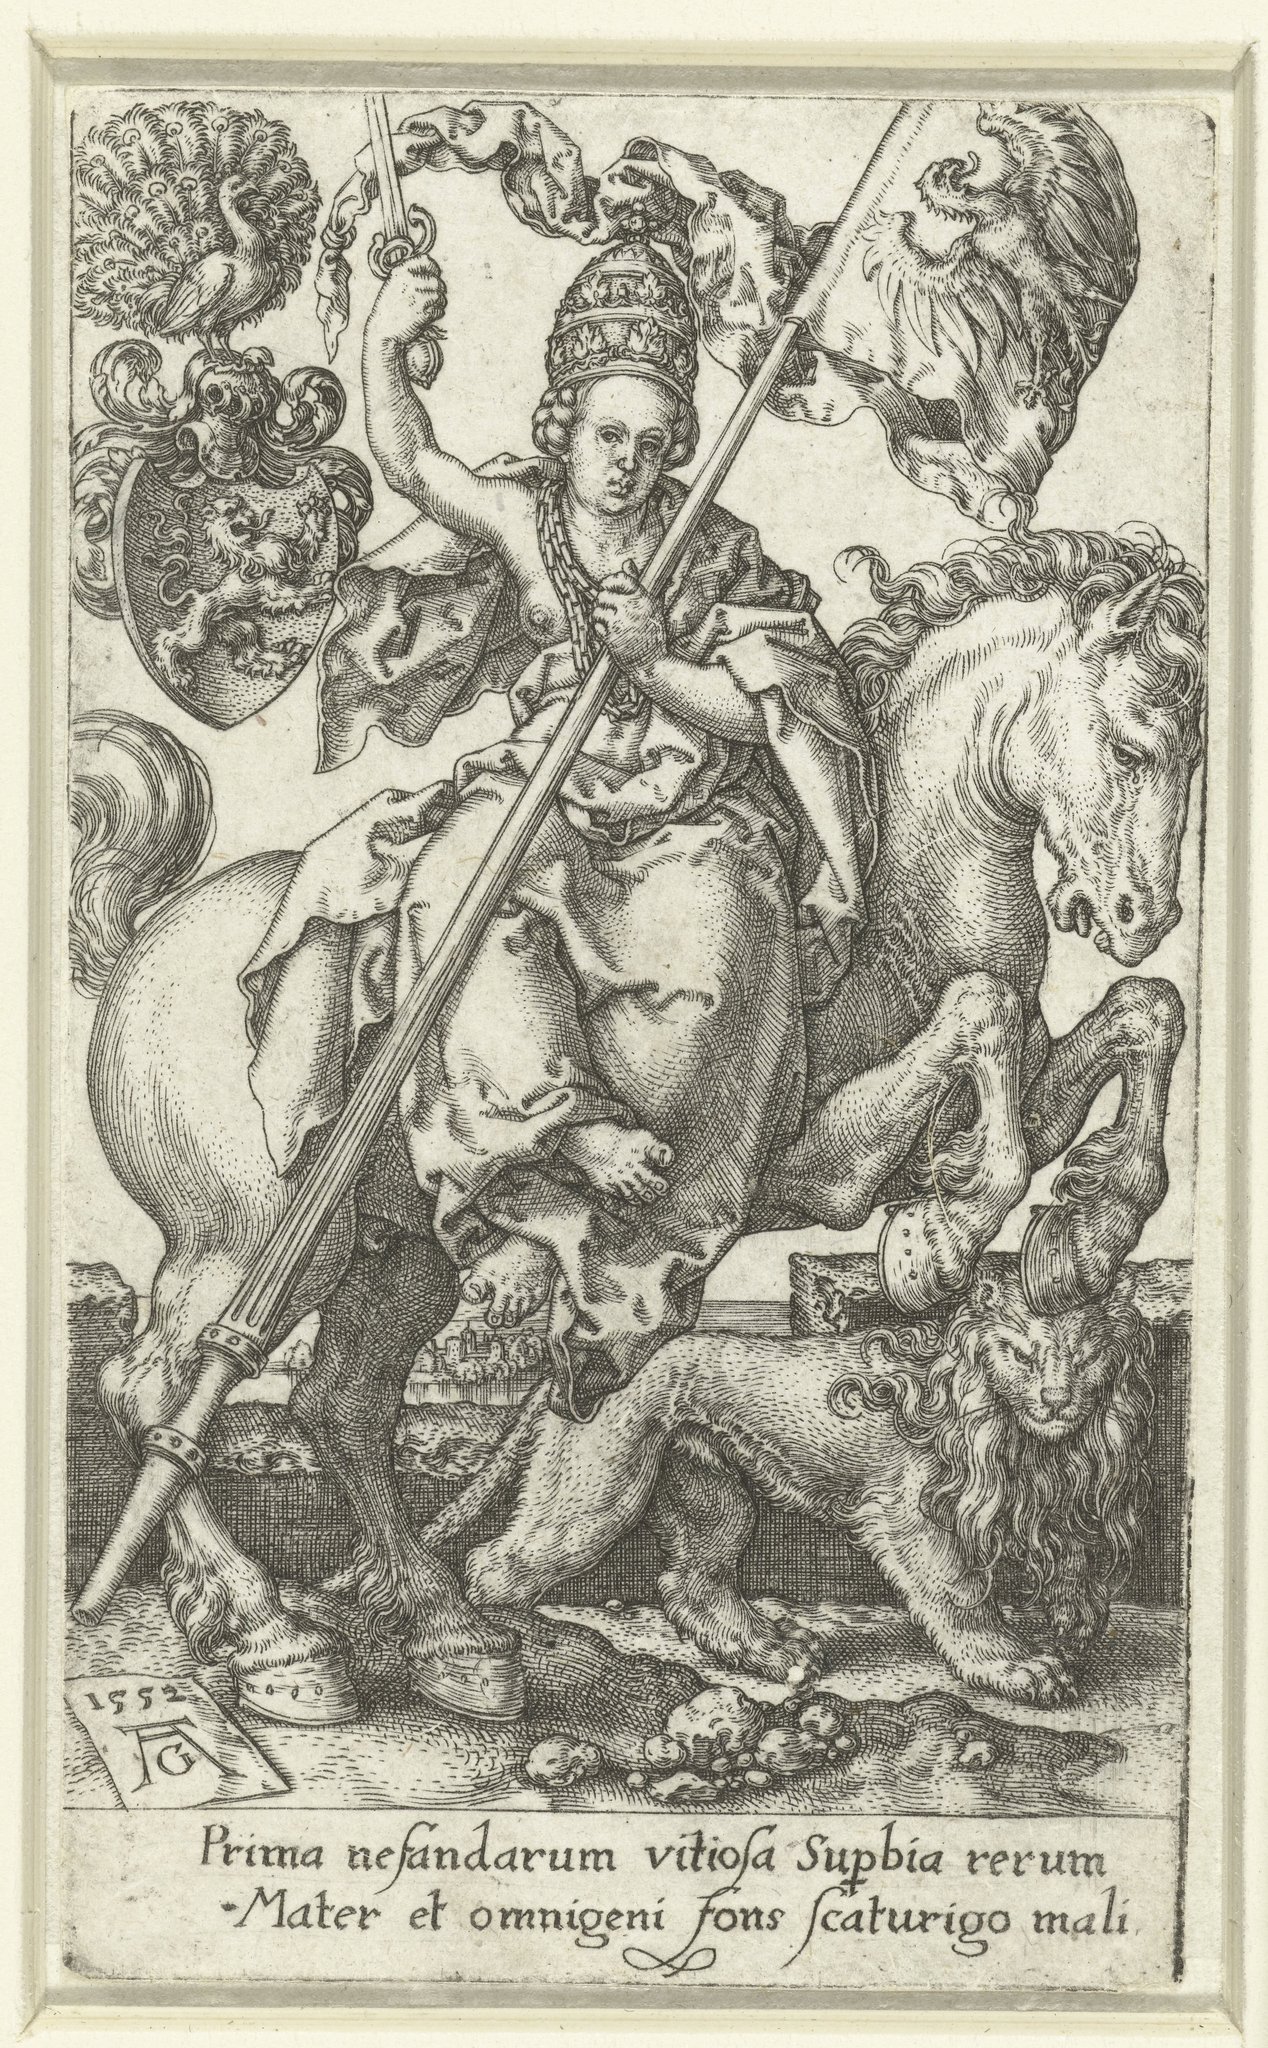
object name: print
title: Hoogmoed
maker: heinrich aldegrever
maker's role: draughtsman, print maker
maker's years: 1502-1561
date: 1552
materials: paper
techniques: engraving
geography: germany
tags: pride; 'superbia' (ripa) ~ personification of one of the seven deadly sins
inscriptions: number: ‘110’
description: Personificatie van de hoogmoed. Vrouw te paard, met een tiara op het hoofd, een zwaard in de rechterhand, in de linker een vaandel met daarop een adelaar. Naast het paard loopt een leeuw. Linksboven een wapenschild met een leeuw, daarboven een pauw. Onder de voorstelling een tweeregelige tekst in het Latijn. Eerste prent uit een serie van zeven.